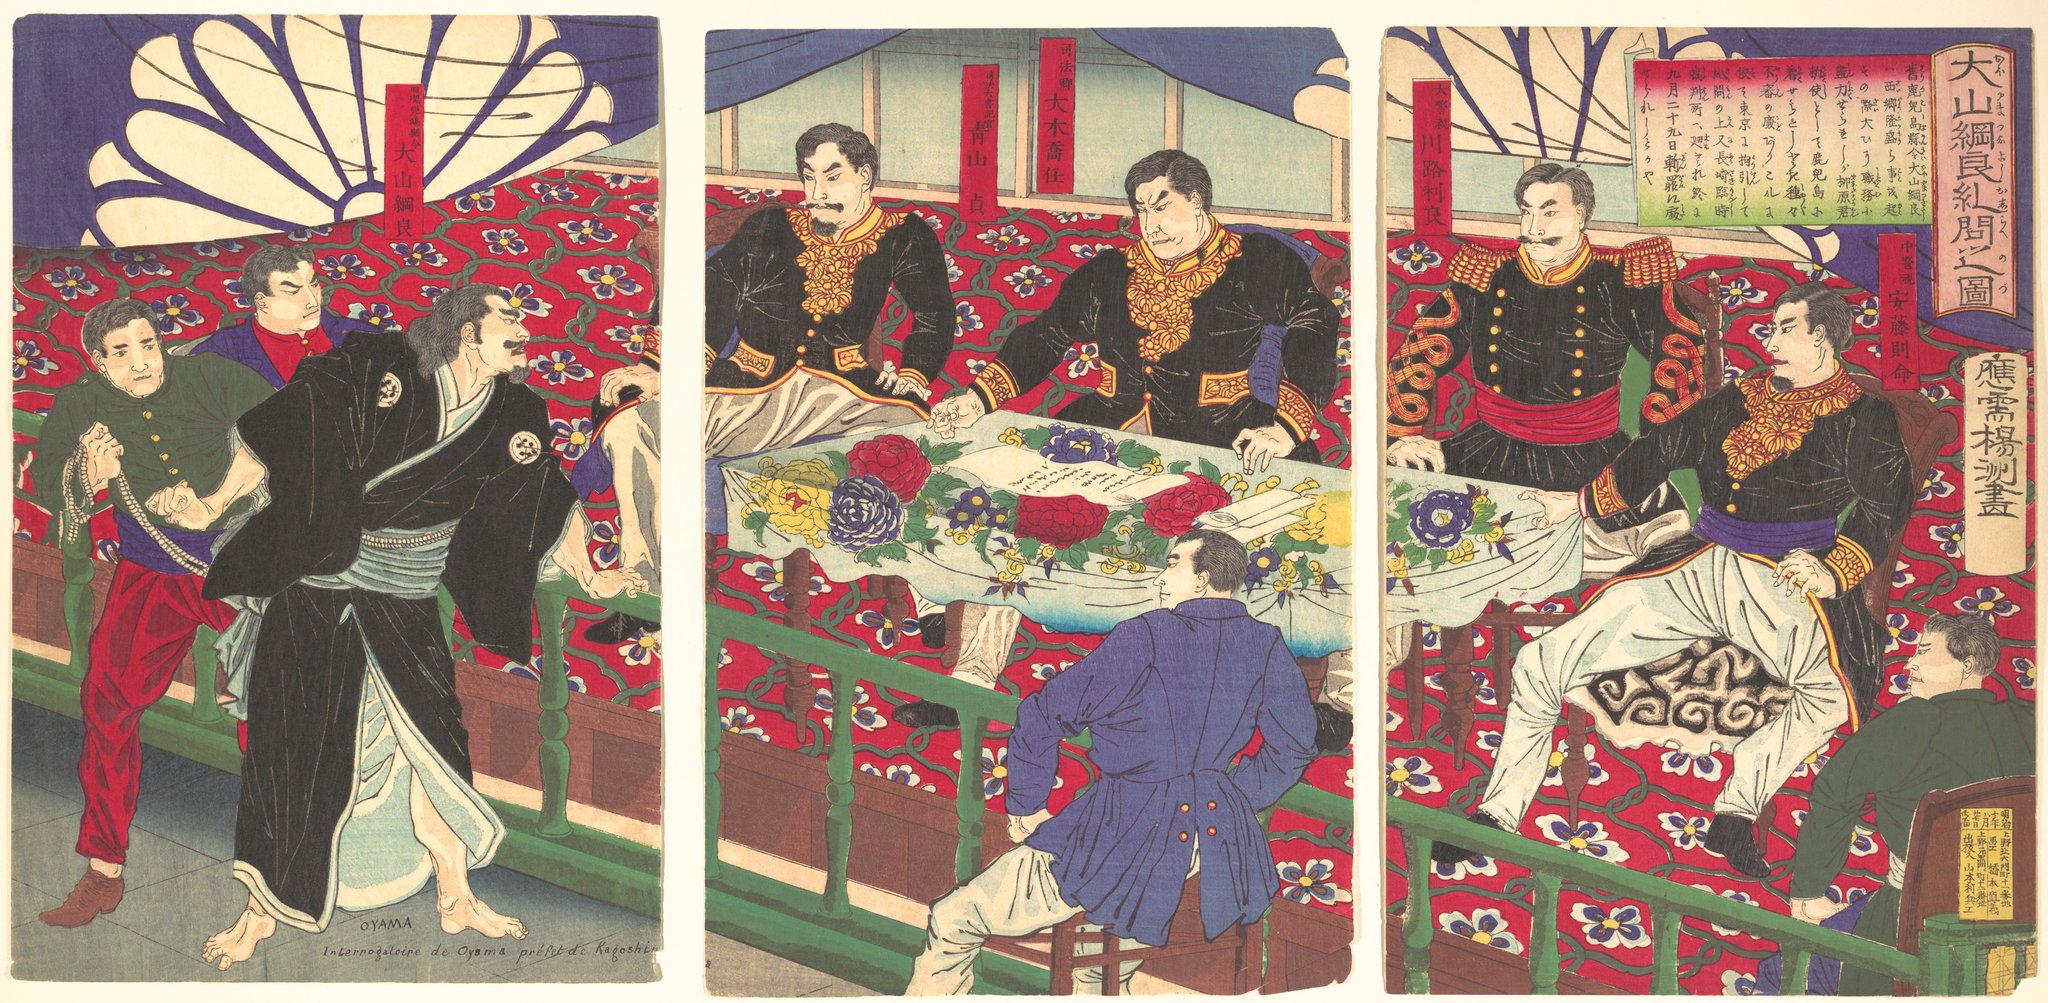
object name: print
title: Oyama Tsunayoshi's Cross Examination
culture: japanese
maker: yōshū (hashimoto) chikanobu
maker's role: artist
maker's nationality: japanese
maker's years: 1838-1912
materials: ink, paper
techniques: woodblock print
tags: men,tables